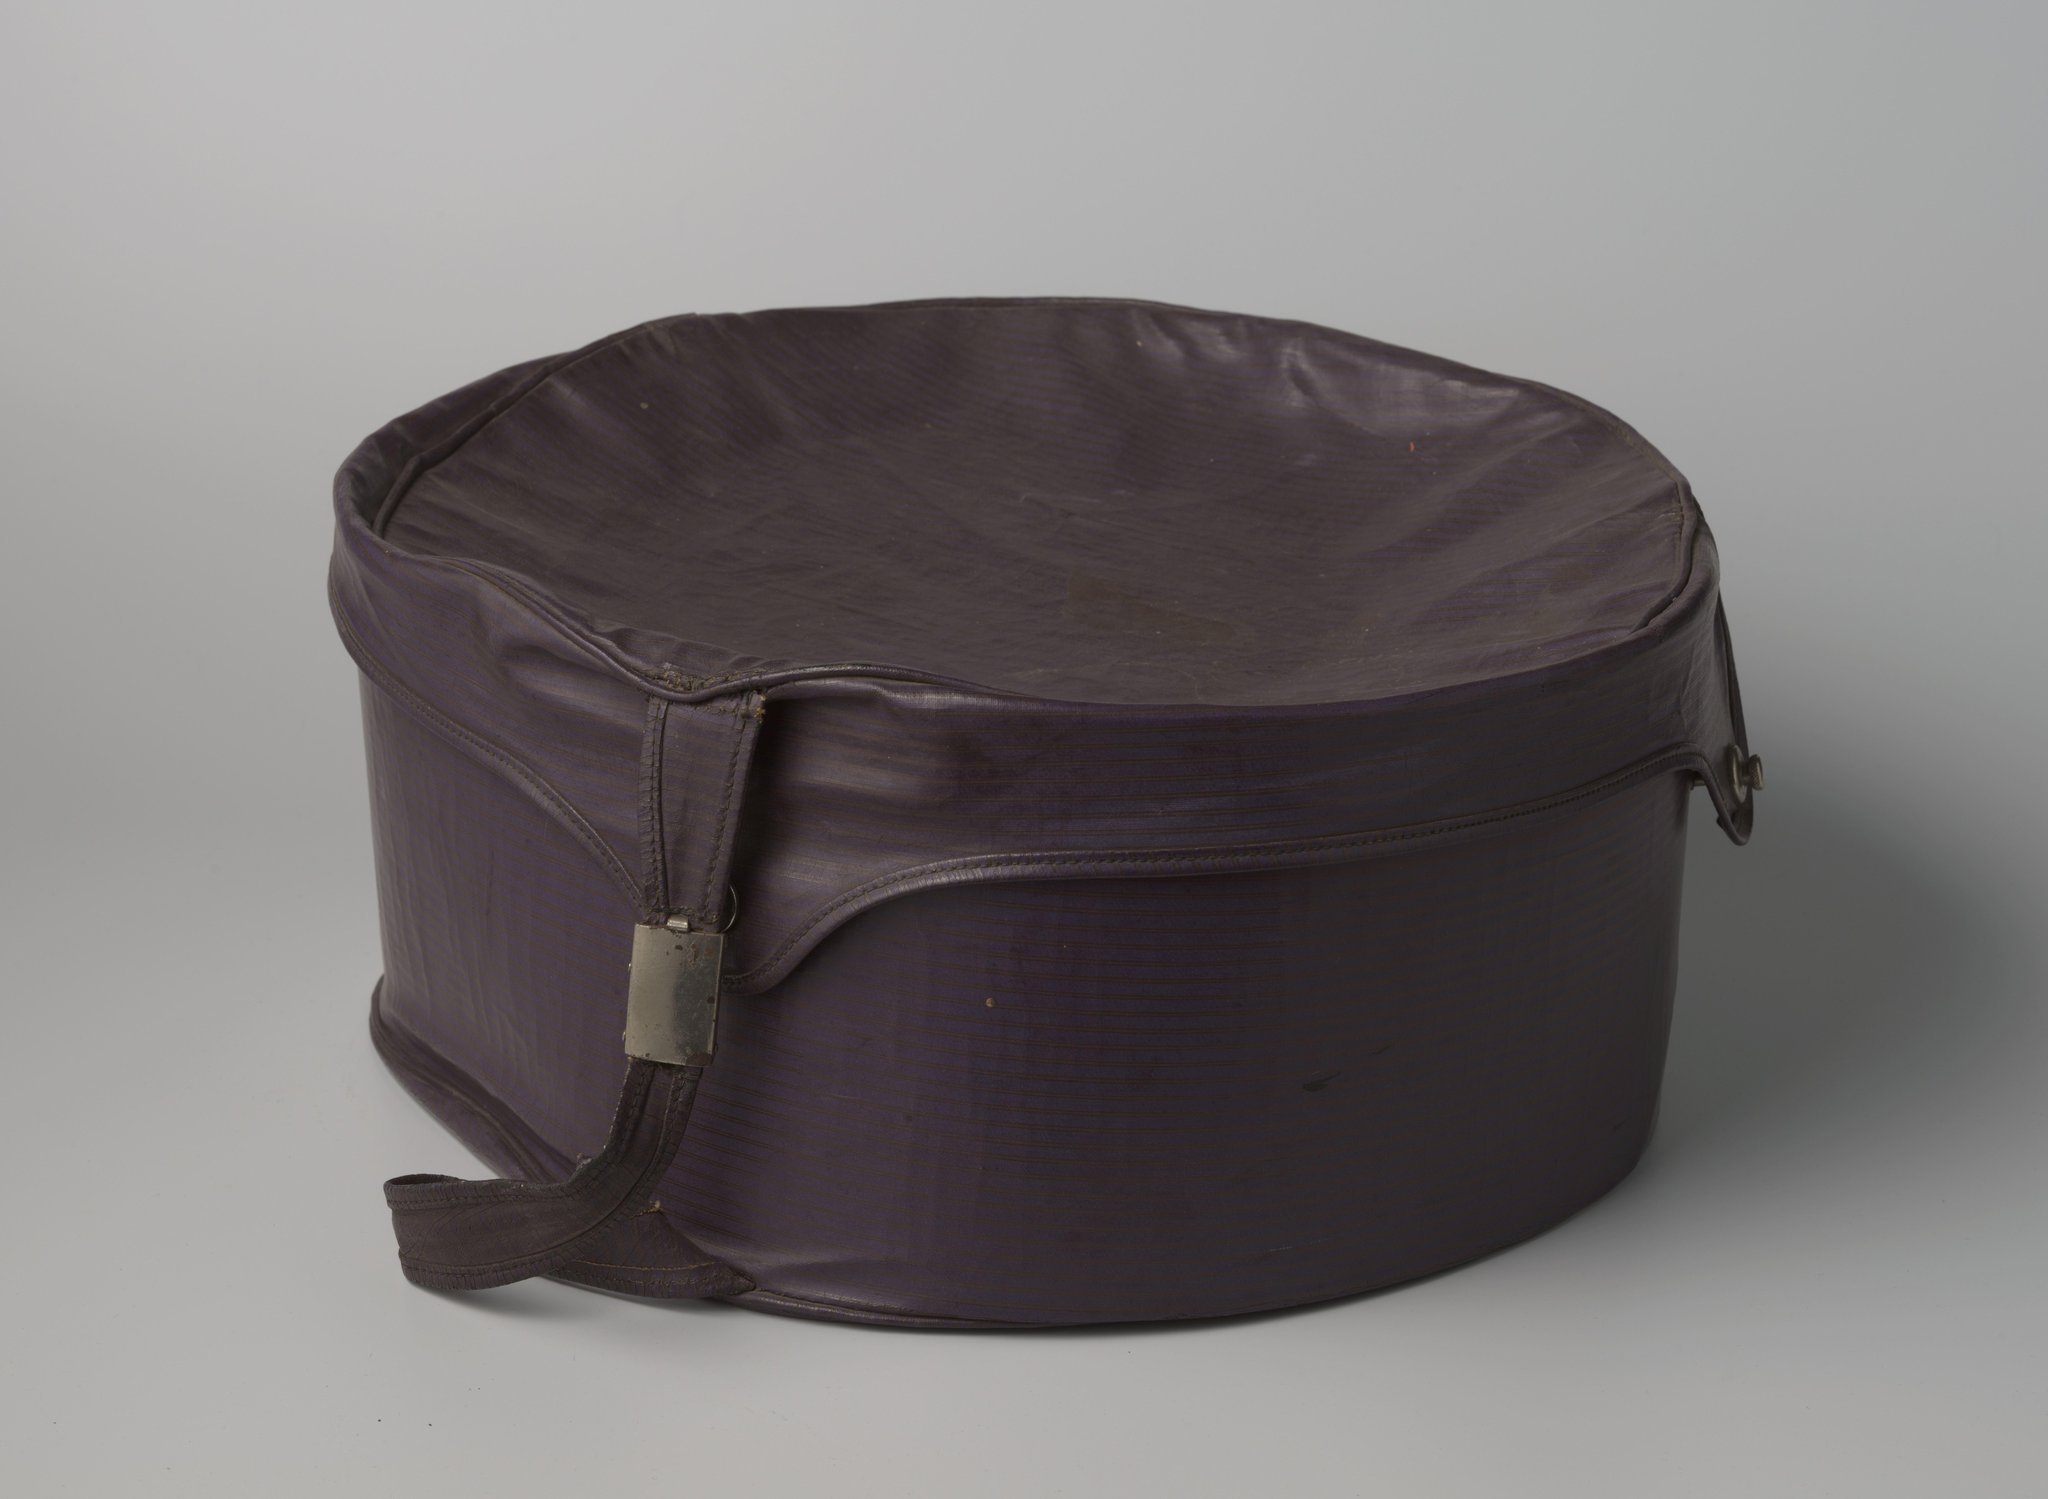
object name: womenswear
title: Hoedendoos van paars zeildoek met streeppatroon; de binnenzijde is bekleed met een stof die bedrukt is met een veelkleurig bloemmotief op een beige fond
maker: Anonymous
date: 1900-1925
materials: textile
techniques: printing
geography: western europe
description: Hoedendoos van paars zeildoek met streeppatroon; de binnenzijde is bekleed met een stof die bedrukt is met een veelkleurig bloemmotief op een beige fond. De scharnierende deksel van de ronde hoedendoos sluit op drie plekken met een drukknoop. Aan de deksel en de onderkant van de doos is een hengsel met slot vastgemaakt.